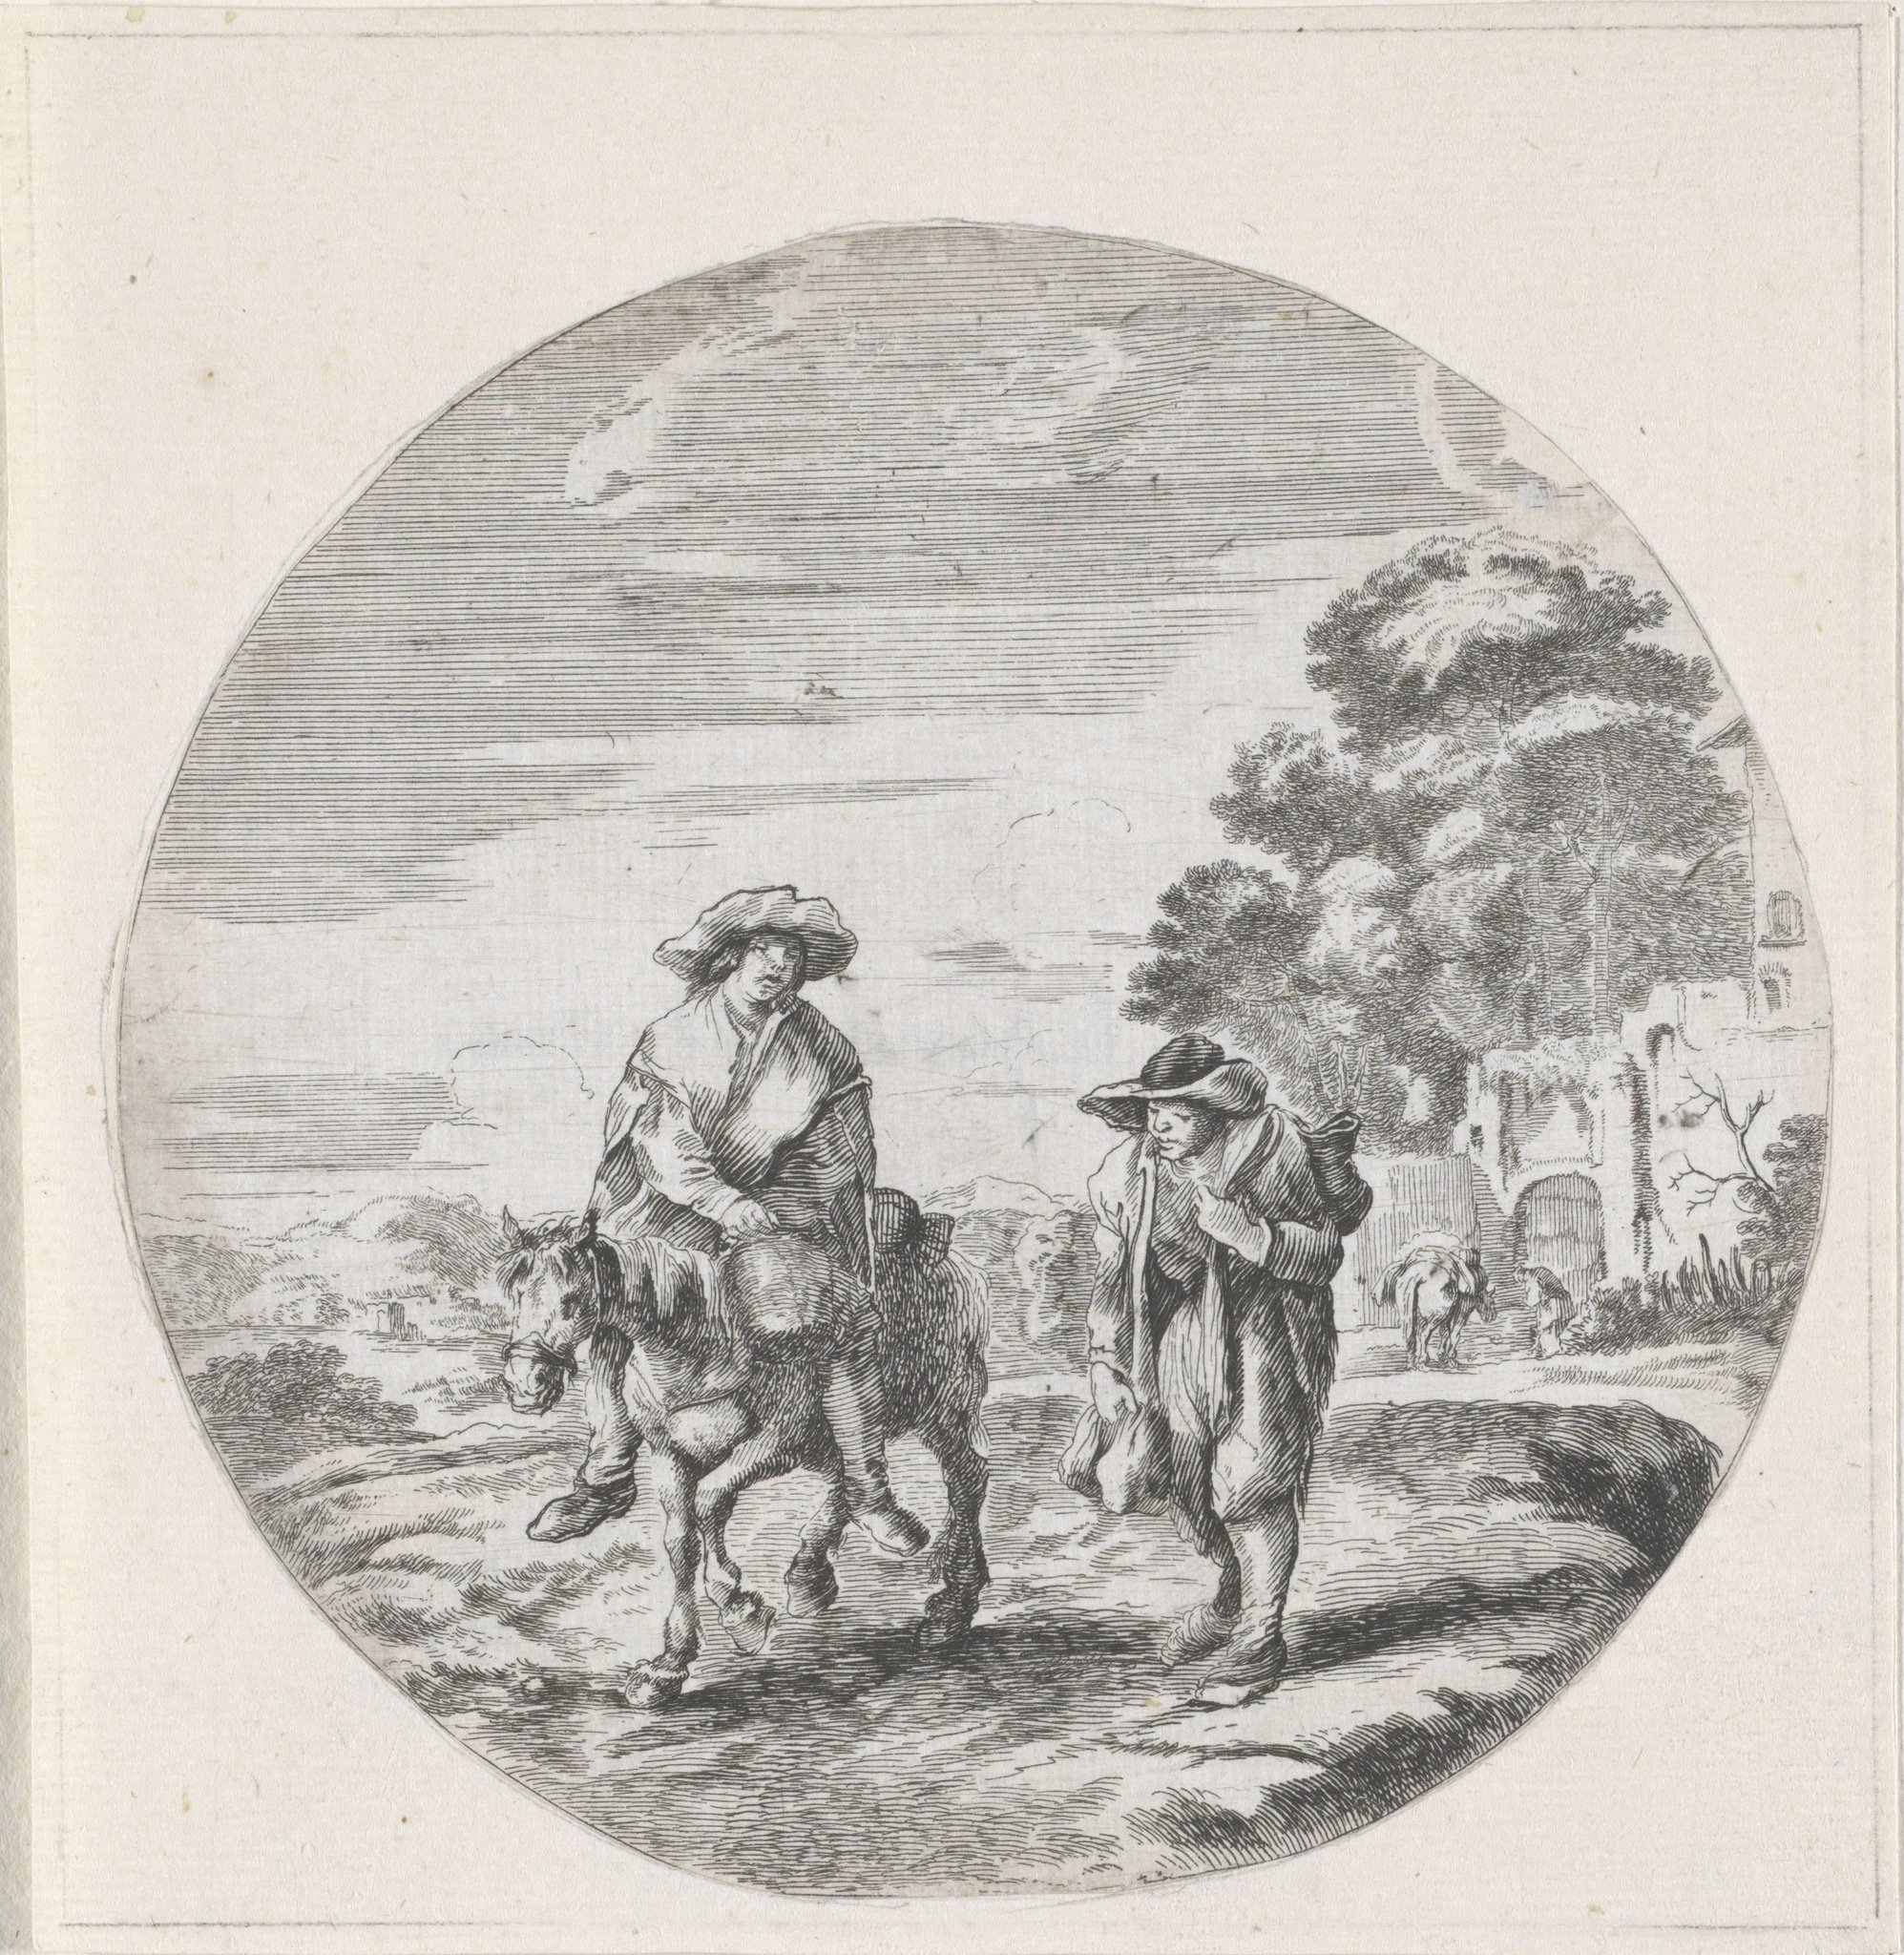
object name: print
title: Boer te paard en boer te voet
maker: Anonymous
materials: paper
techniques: etching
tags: riding a horse, ass, or mule; rider, horseman, farmers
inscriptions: collector's mark: Lugt 240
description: Een boer te paard en een boer te voet in een landschap. Op de achtergrond rechts een huis.